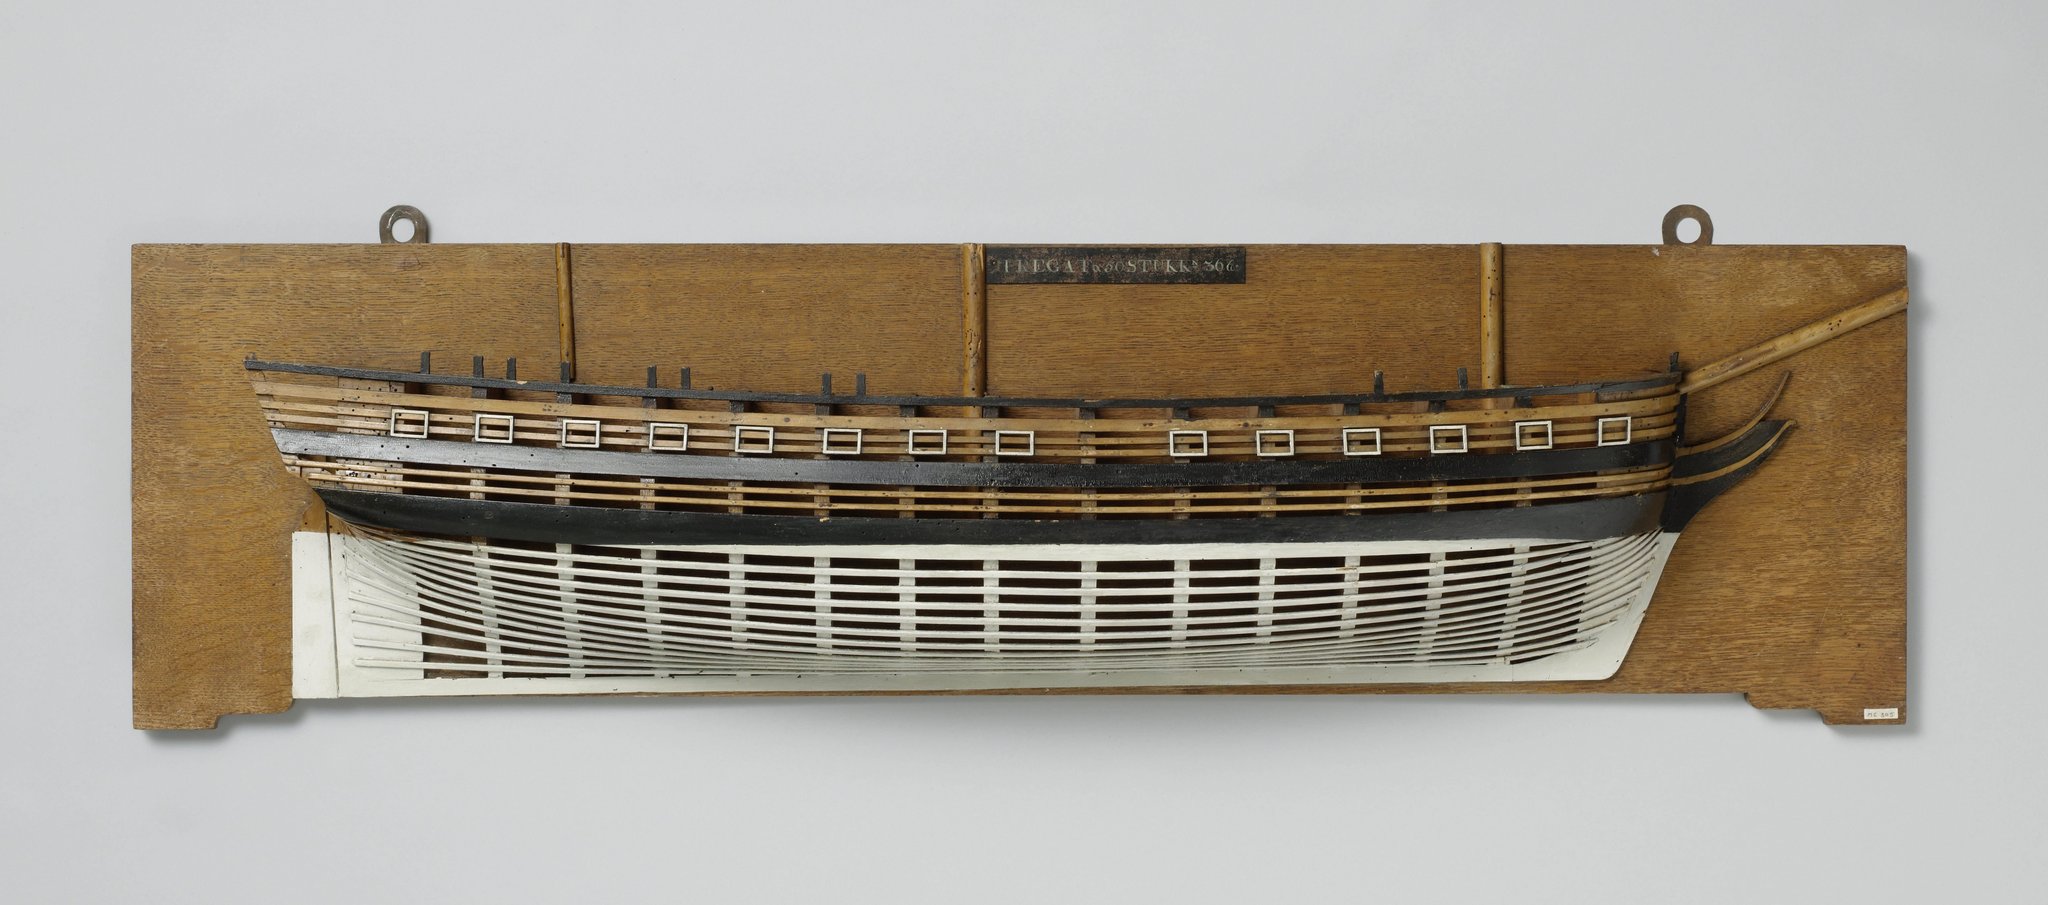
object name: half model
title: Half Model of a 50-Gun Frigate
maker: Anonymous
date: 1780-1820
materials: wood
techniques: polychromy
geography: netherlands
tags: minerva (schip)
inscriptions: inscription, top centre, on a rectangular black label: ‘FREGAT a 50 STUKKn 36 lb’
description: Gepolychromeerd mallenmodel (stuurboord) van een driemaster. Vijftien geschutpoorten op het geschutdek en negen geschutposities op het bovendek. Gewrongen spiegel, hol wulf, geen details van hek of zijgalerij. Recht roer met vierkante roerkoning. Zeeg aan beide uiteinden iets oplopend, twee berghouten en één reehout. Gepiekt rondspant.